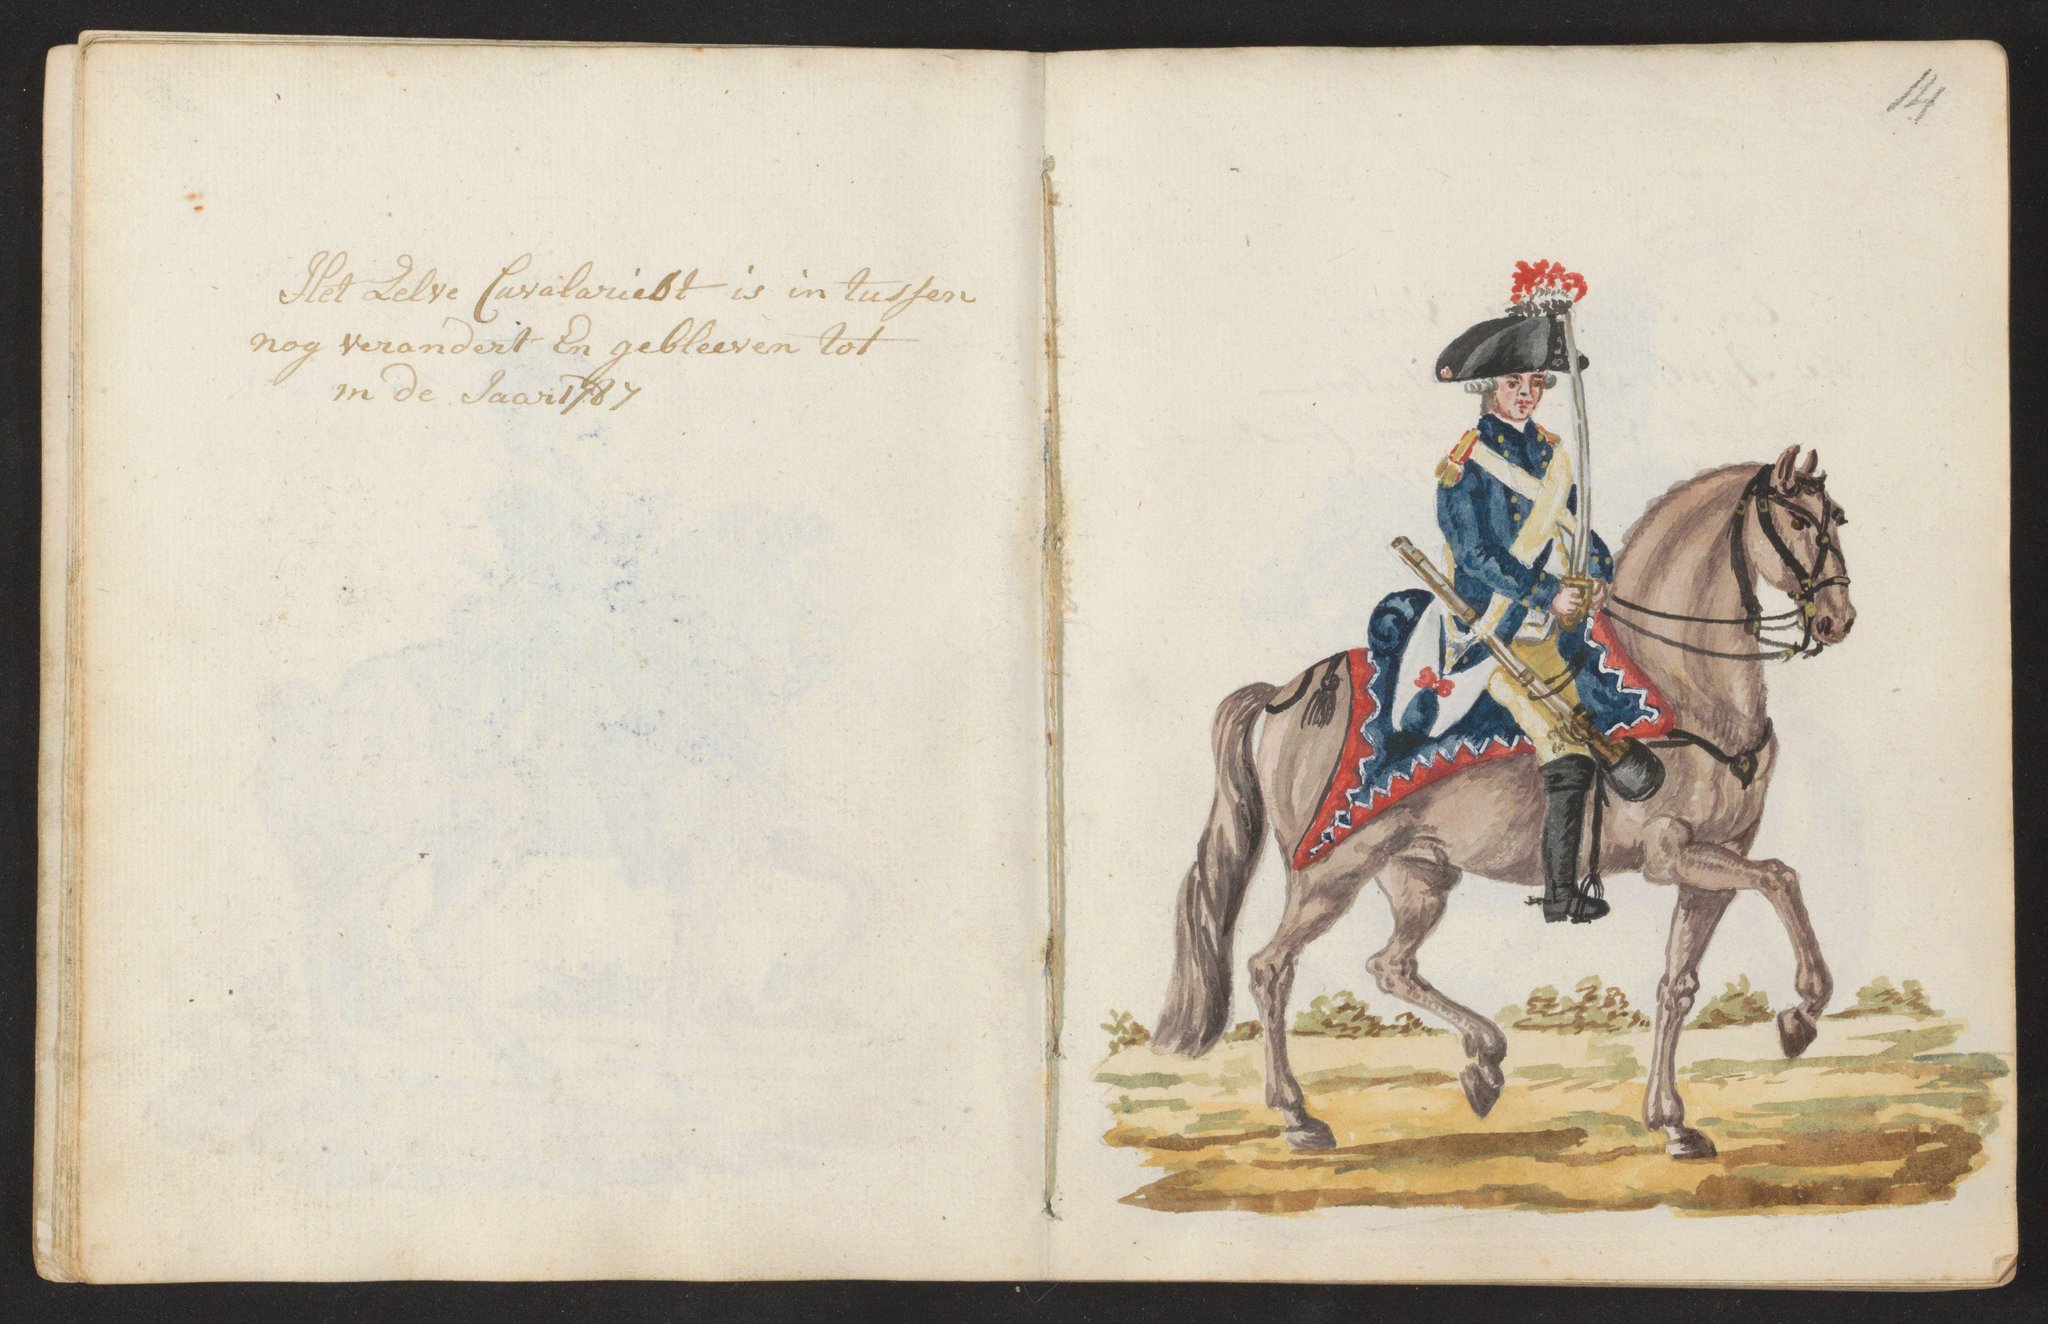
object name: drawing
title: Uniform van de cavalerie van het Amsterdamse exercitiegenootschap 1787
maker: s.g. casten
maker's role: draughtsman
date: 1795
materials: paper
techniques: writing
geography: amsterdam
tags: (military) uniforms (+ cavalry, horsemen), (military) uniforms (+ citizen soldiery, civil guard, citizen militia), patriots (1780-1795)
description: Het nieuwe uniform van de cavalerie van het Amsterdamse exercitiegenootschap. Onderdeel van het tweede hoofdstuk over de nieuwe Amsterdamse schutterij tussen 1783-1787. In het schetsboek met gekleurde tekeningen van de uniformen van militairen en leden van de schutterij uit de periode 1770 tot 1795-1796.